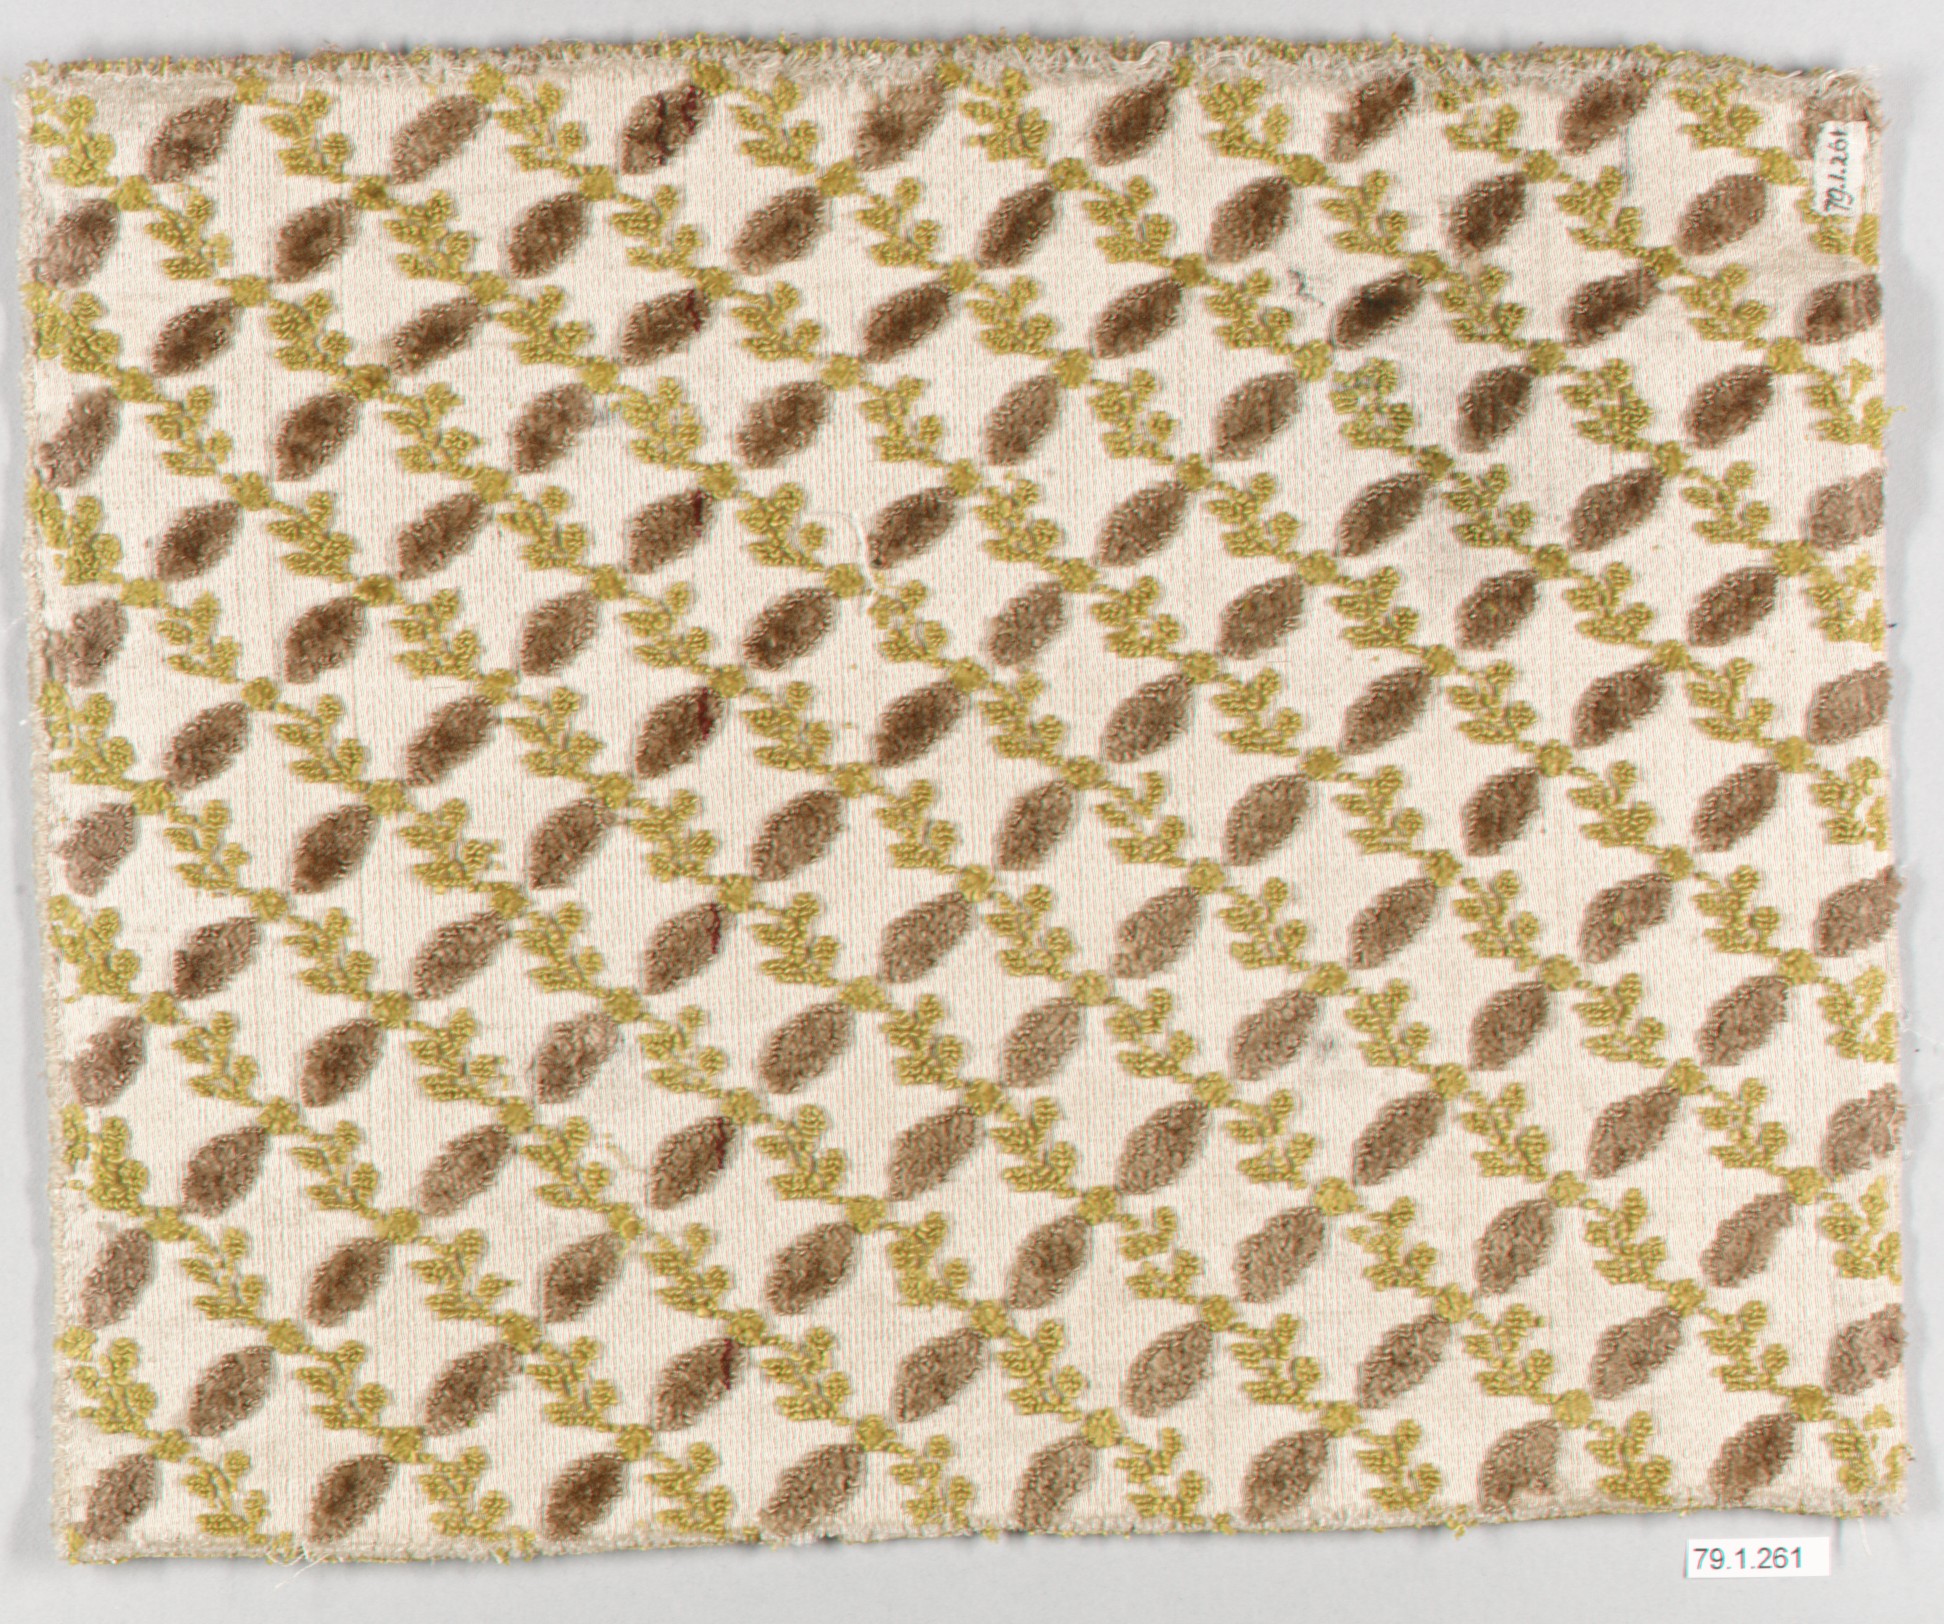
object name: piece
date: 1501-1600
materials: silk